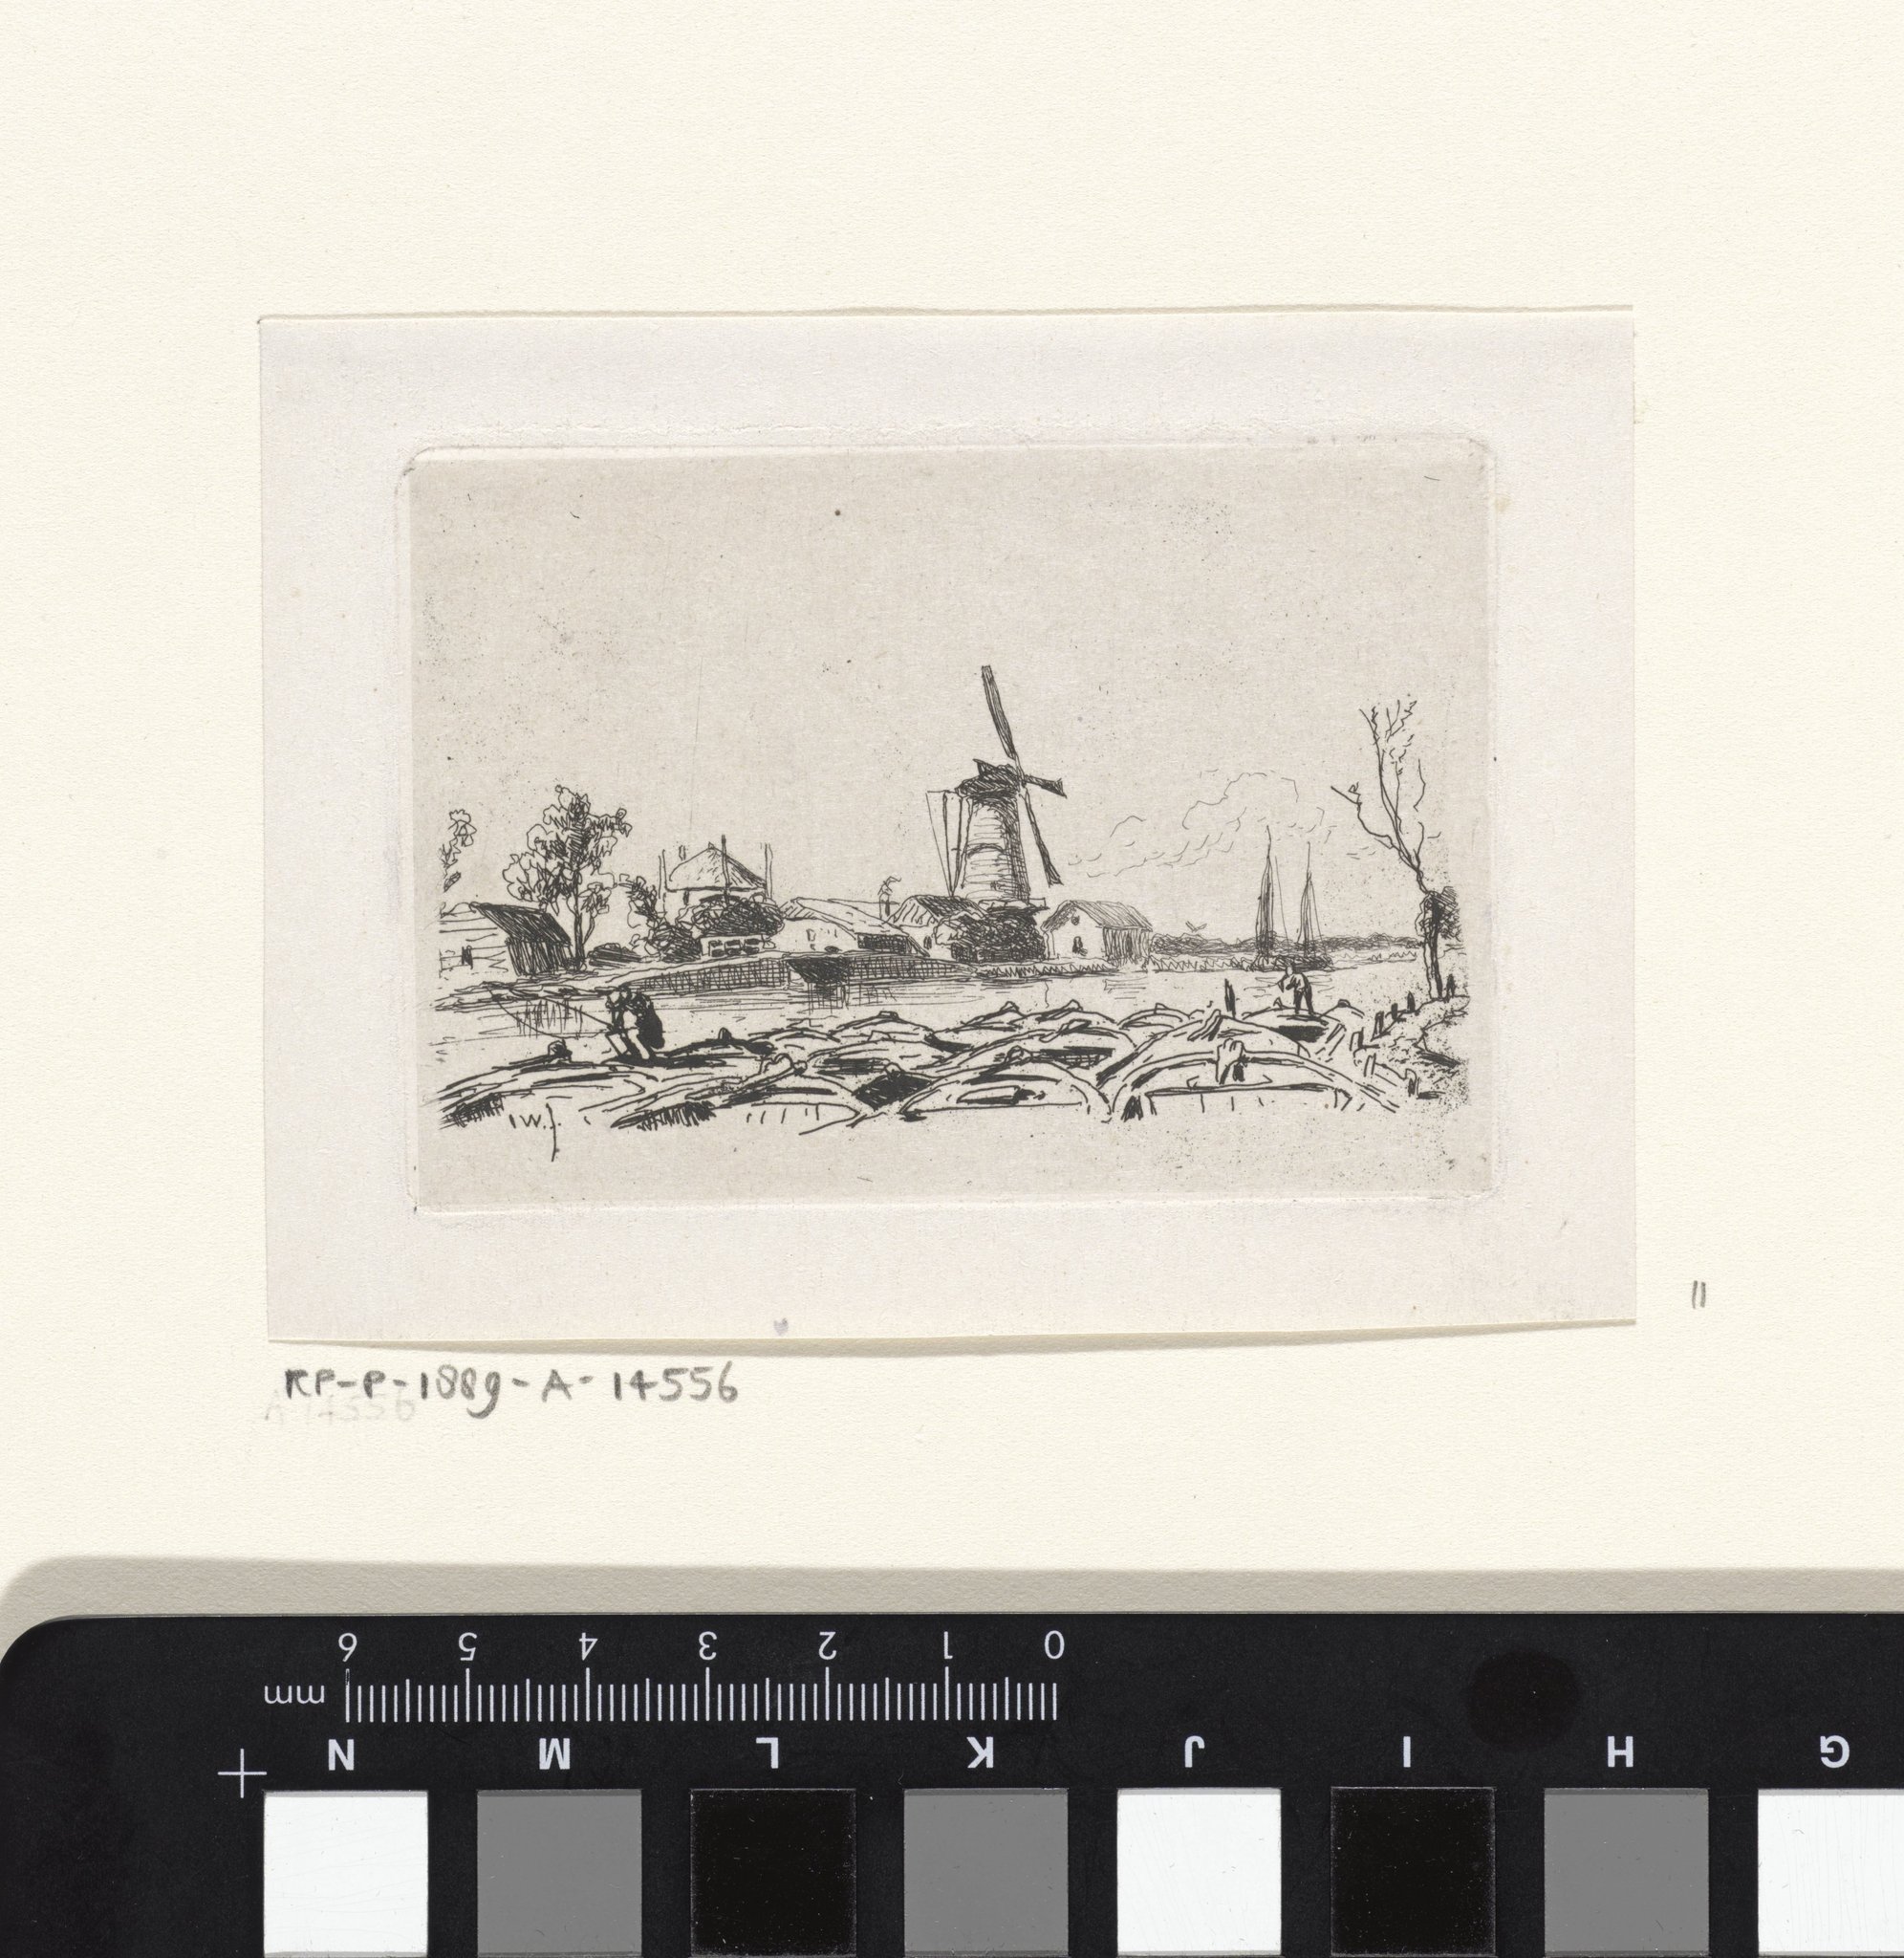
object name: print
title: Gezicht op Leidschendam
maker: jan weissenbruch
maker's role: painter, print maker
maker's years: 1822-1880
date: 1856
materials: paper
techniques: etching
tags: river, rowing-boat, canoe, etc., windmill in landscape, windmill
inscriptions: collector's mark: Lugt 2228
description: Gezicht op een rivier bij Leidschendam met enkele boten. In de verte staat een molen tussen enkele huizen.